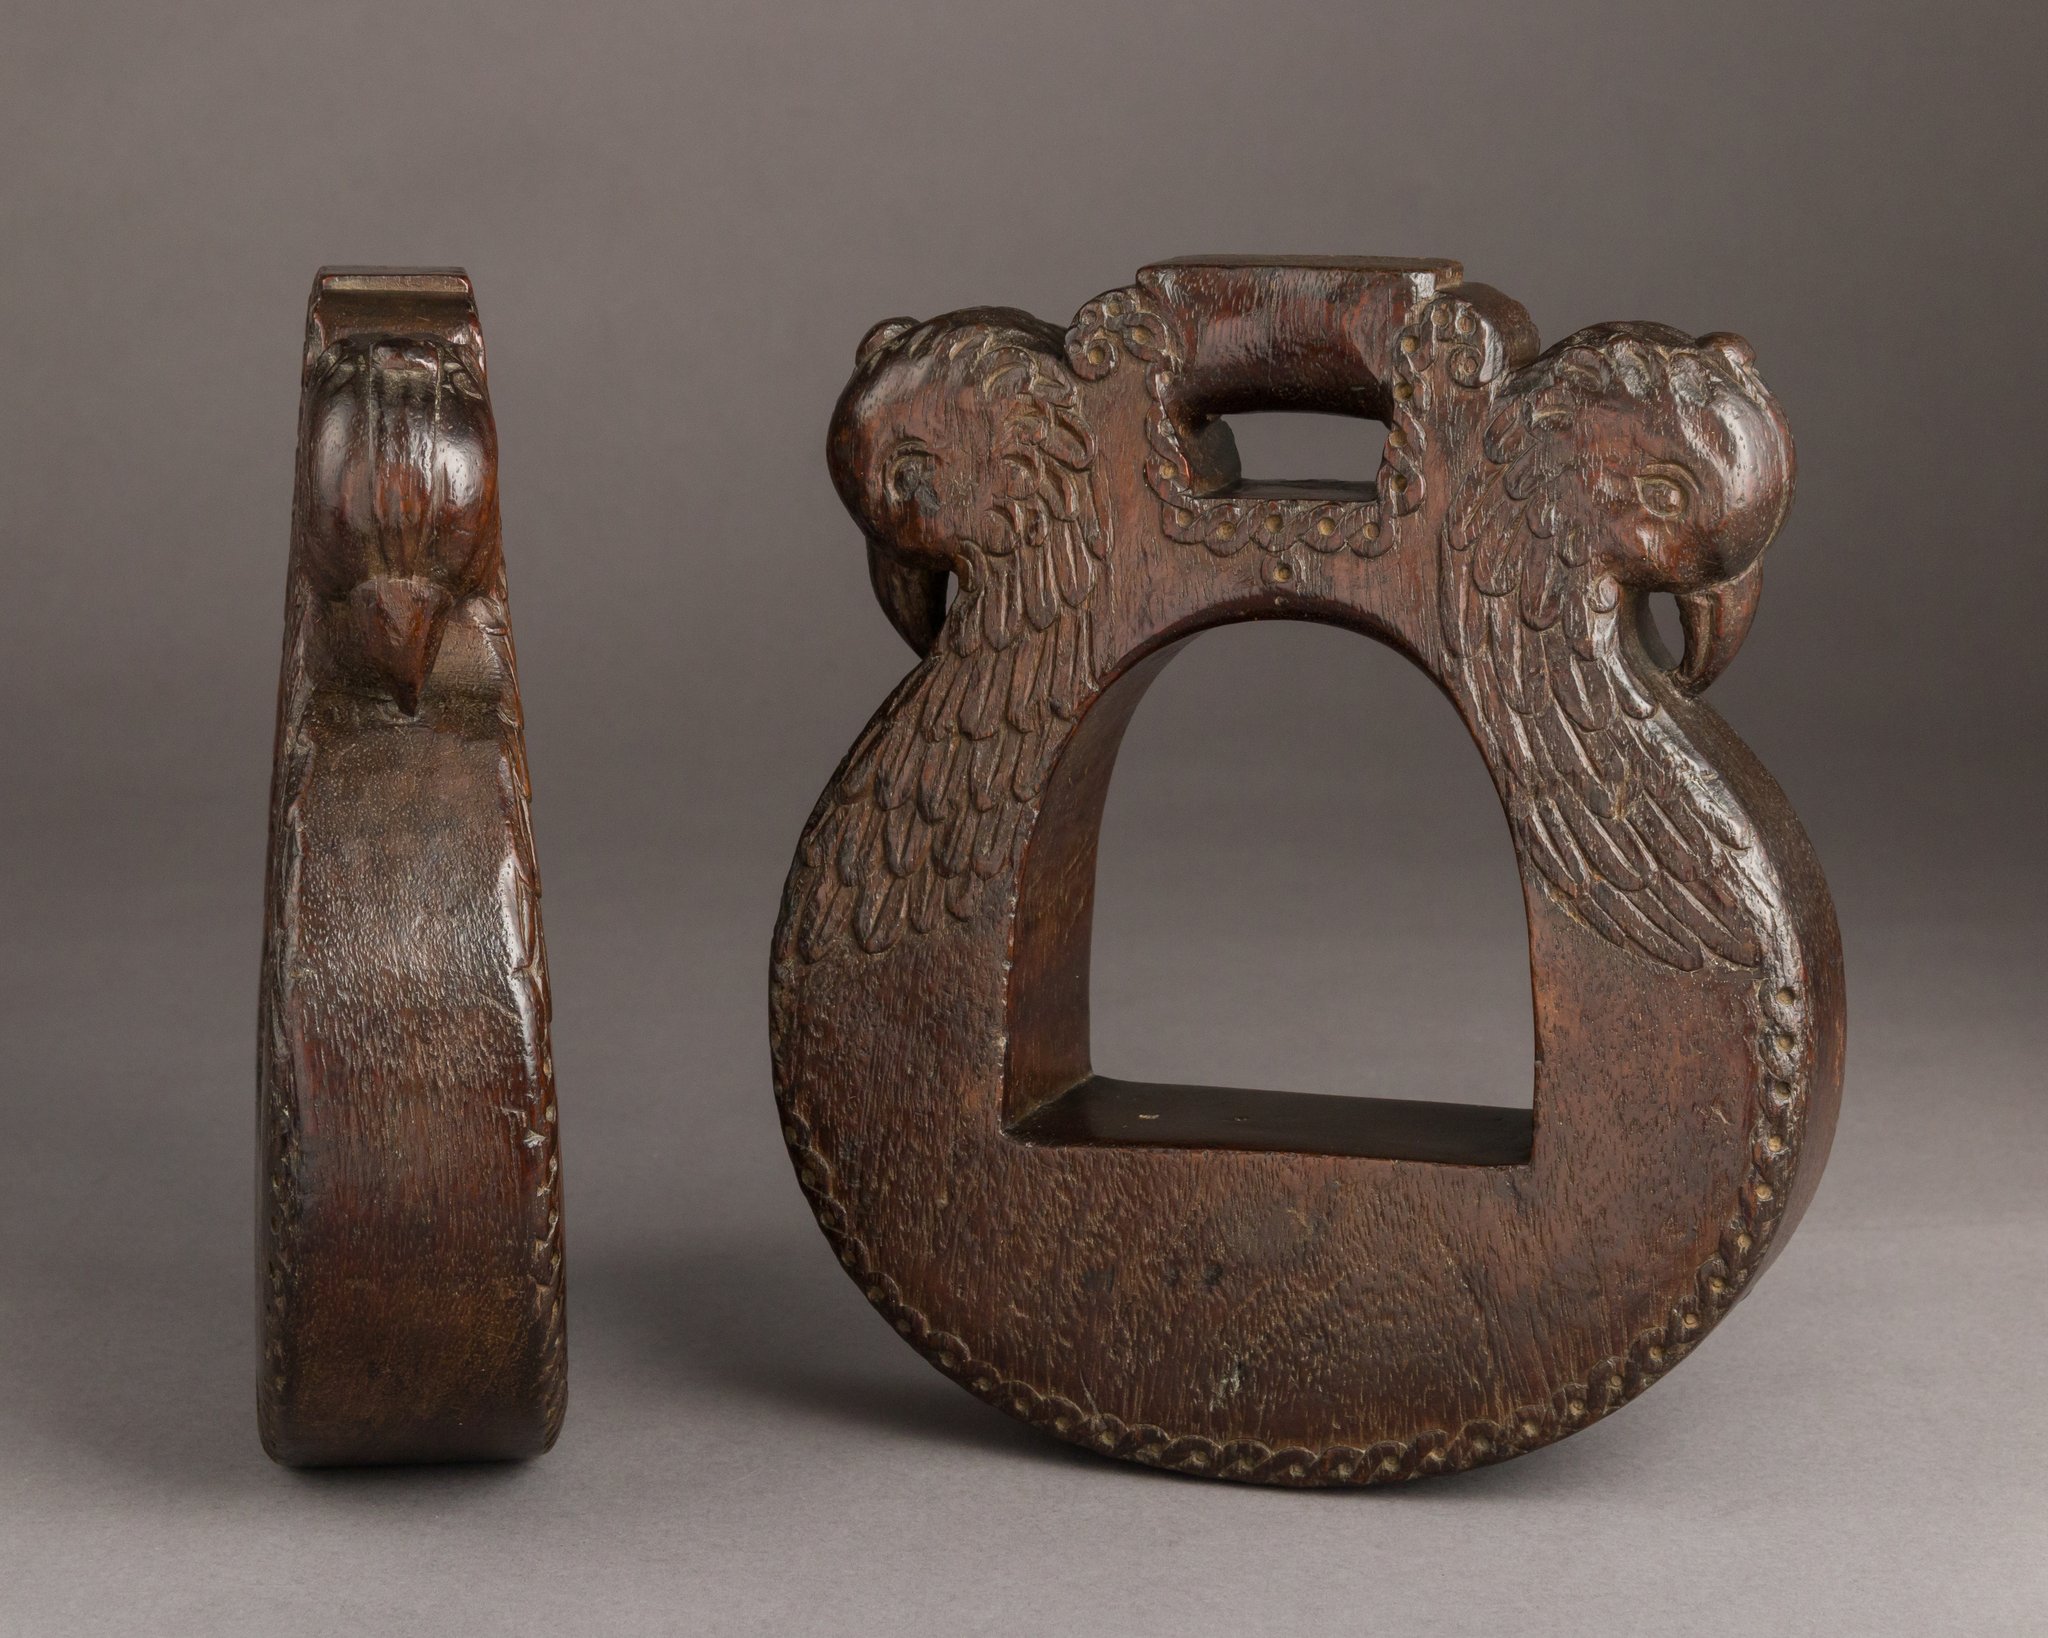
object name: stirrup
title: Pair of Stirrups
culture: guatemalan or south mexican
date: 1801-1900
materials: wood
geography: guatemala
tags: birds